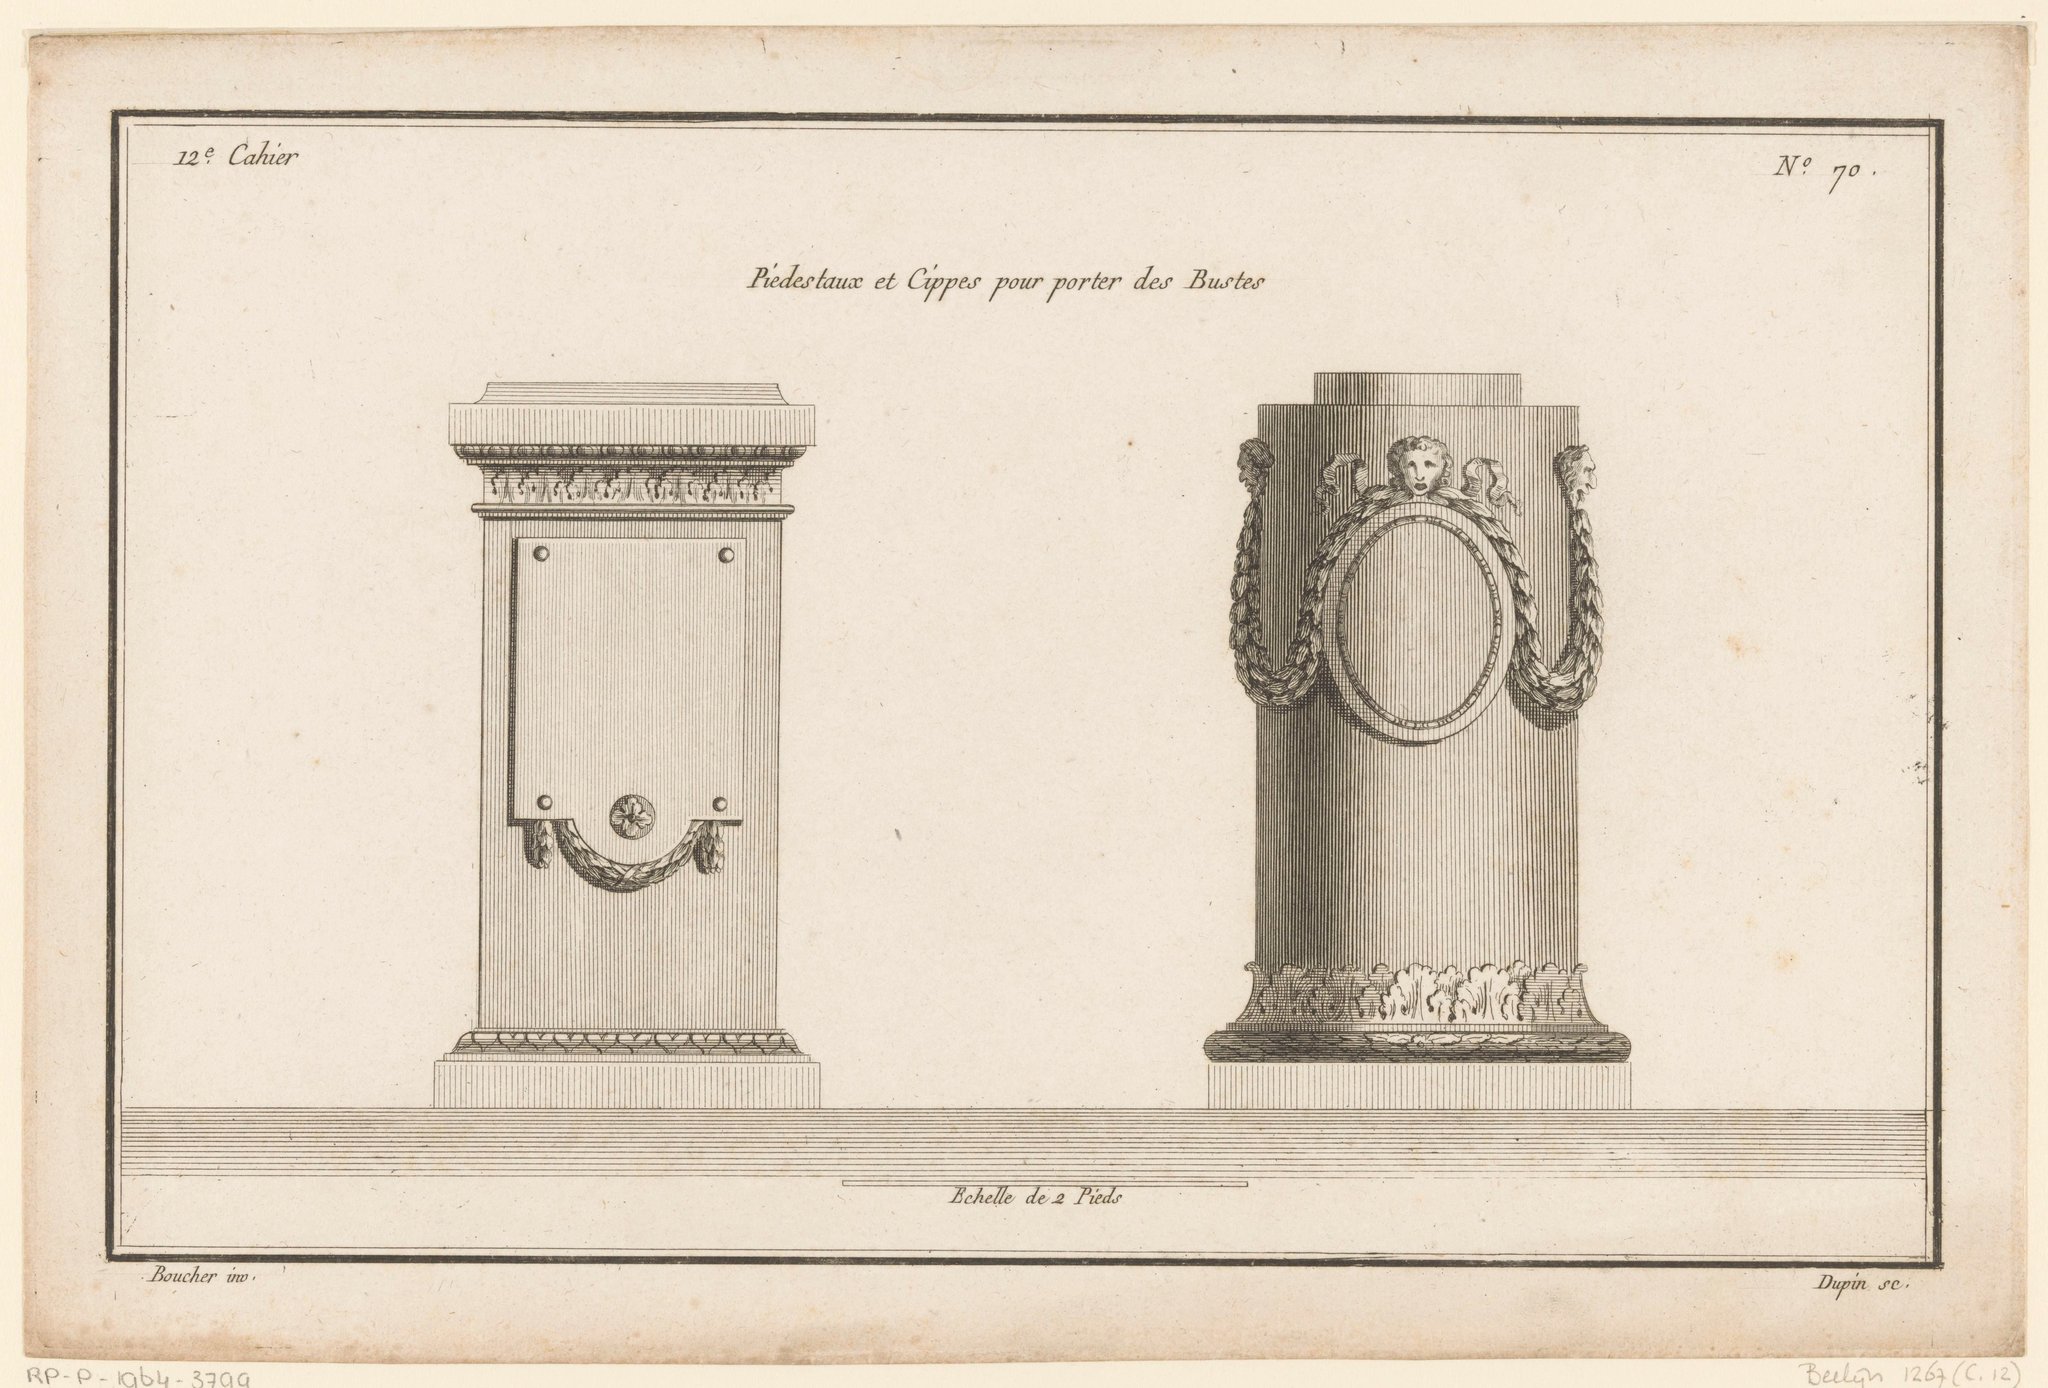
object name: print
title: 12e Cahier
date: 1772-1779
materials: paper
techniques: engraving, etching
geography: paris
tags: column, pillar ~ architecture, pedestal of a piece of sculpture (perhaps in the form of a herm), mask, mascaron ~ ornament, ornament ~ festoon, garland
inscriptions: collector's mark: Lugt 2760, collector's mark: Lugt 2228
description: Links een geornamenteerd voetstuk met tablet en guirlande. Rechts een geornamenteerde zuil met medaillon, guirlandes en maskers. Prentnummer 70.